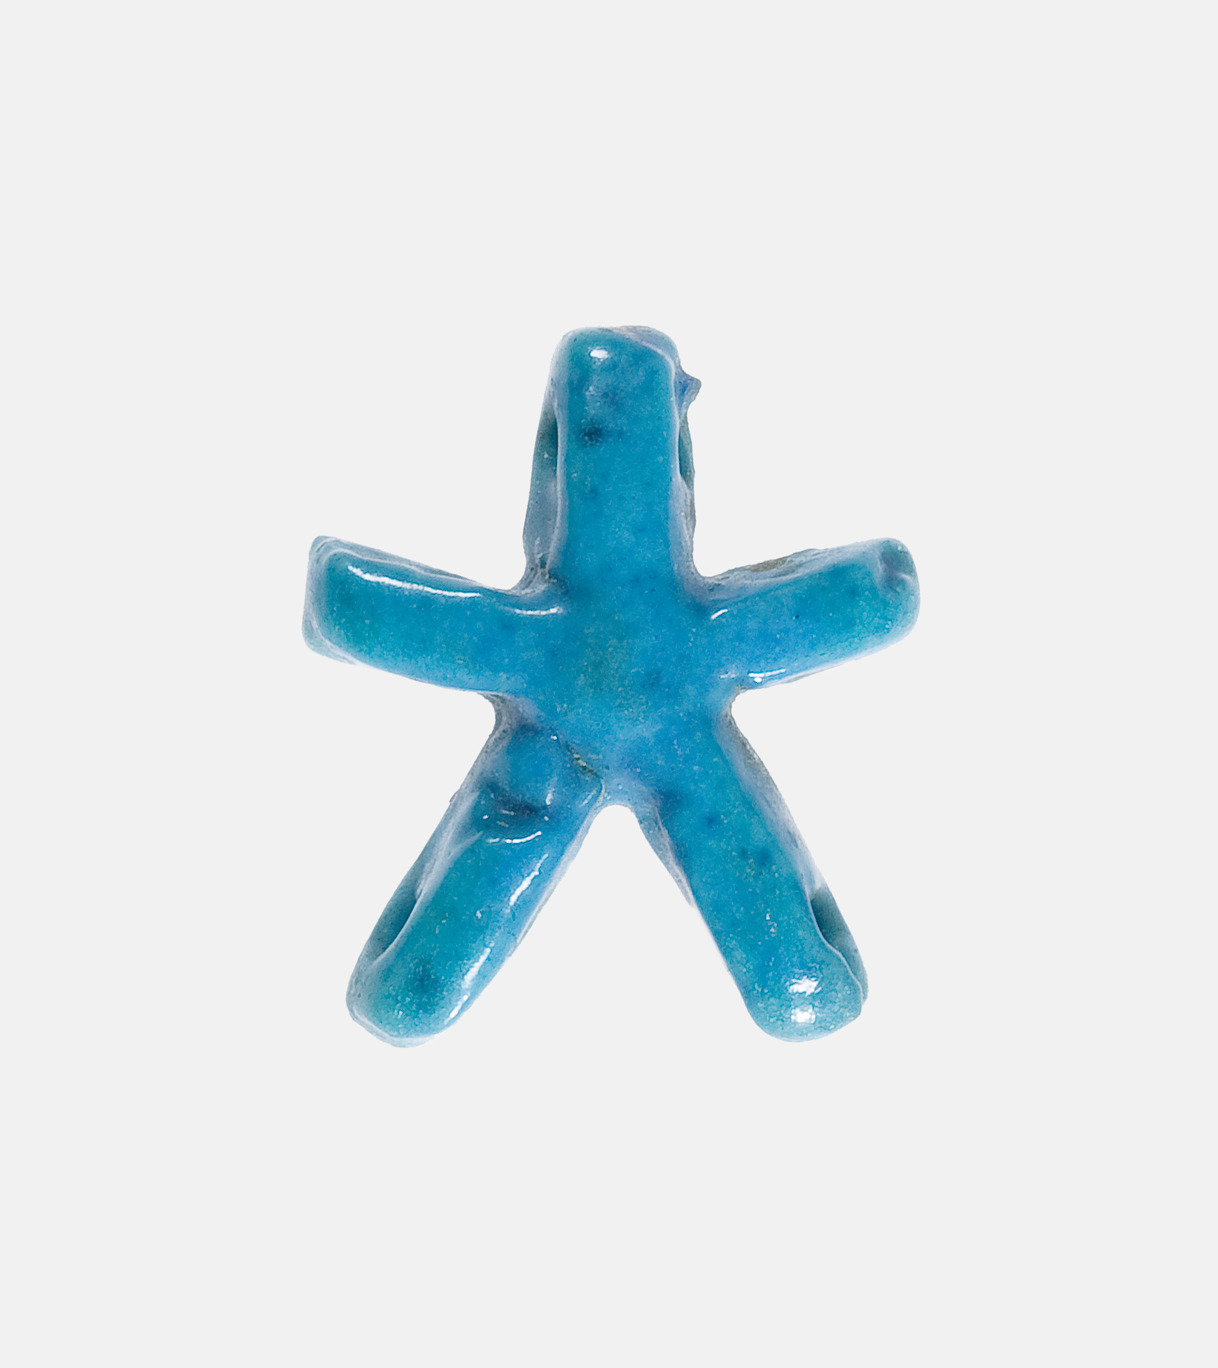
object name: jewelry element in the shape of a star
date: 1390-1352 BCE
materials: faience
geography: egypt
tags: stars